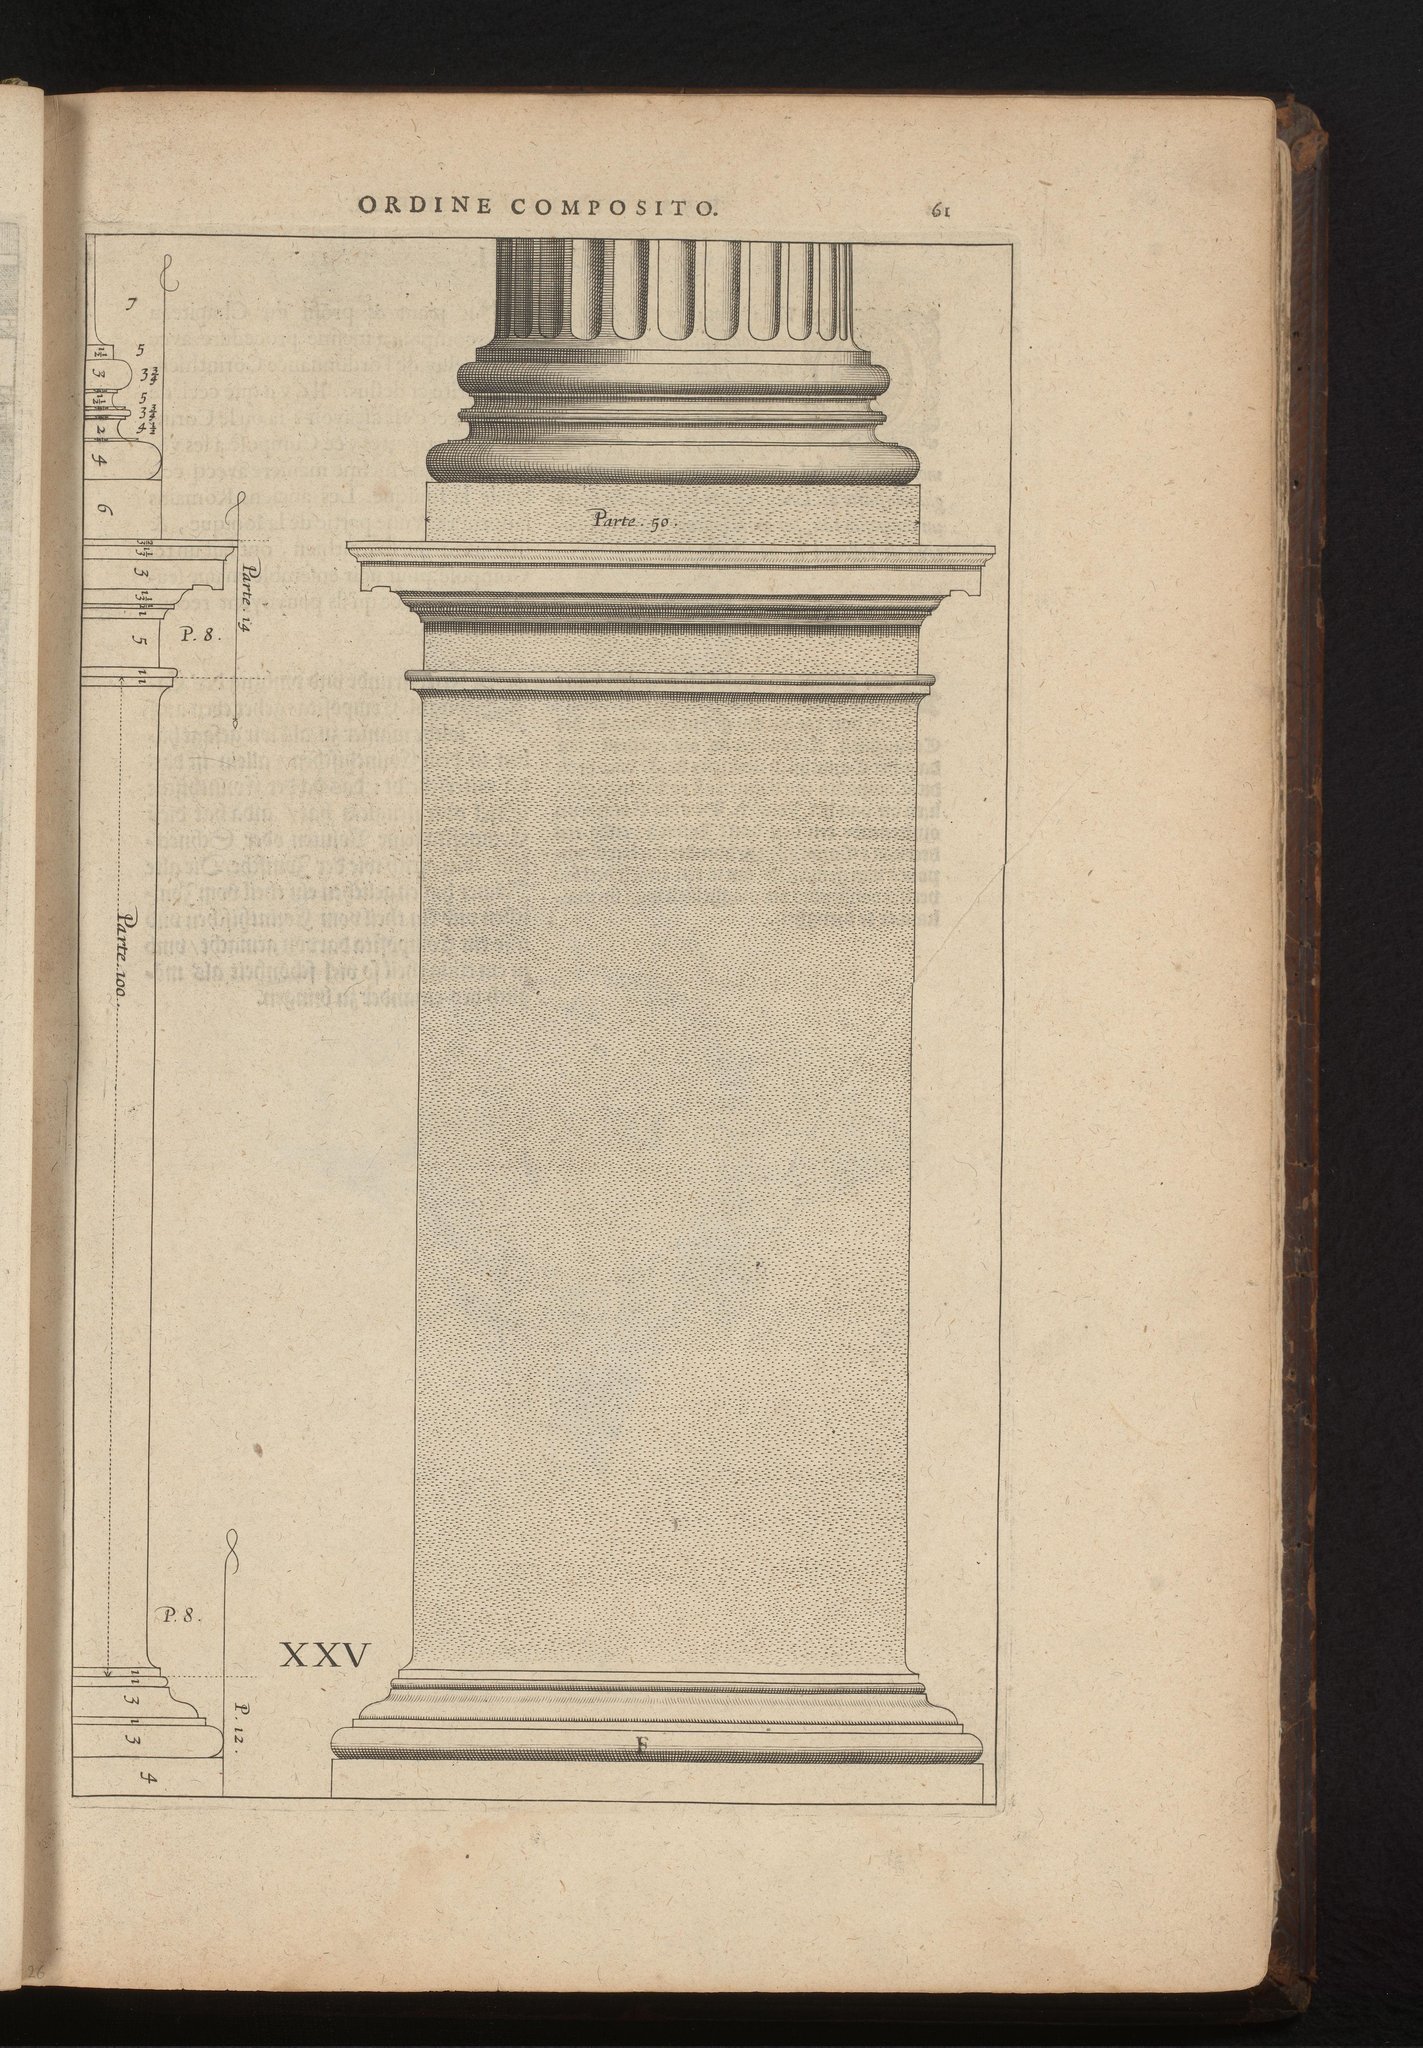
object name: print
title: Composiet basement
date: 1640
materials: paper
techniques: engraving, letterpress printing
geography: amsterdam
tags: composite order ~ architecture, orders, order-books ~ architecture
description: Prent uit: Vignola, Giacomo Barozzi da. Regola delli cinque ordini d'architettura (...). Amsterdam: Johannes Willemszoon en Cornelis Blaeu, 1640, p. 61.